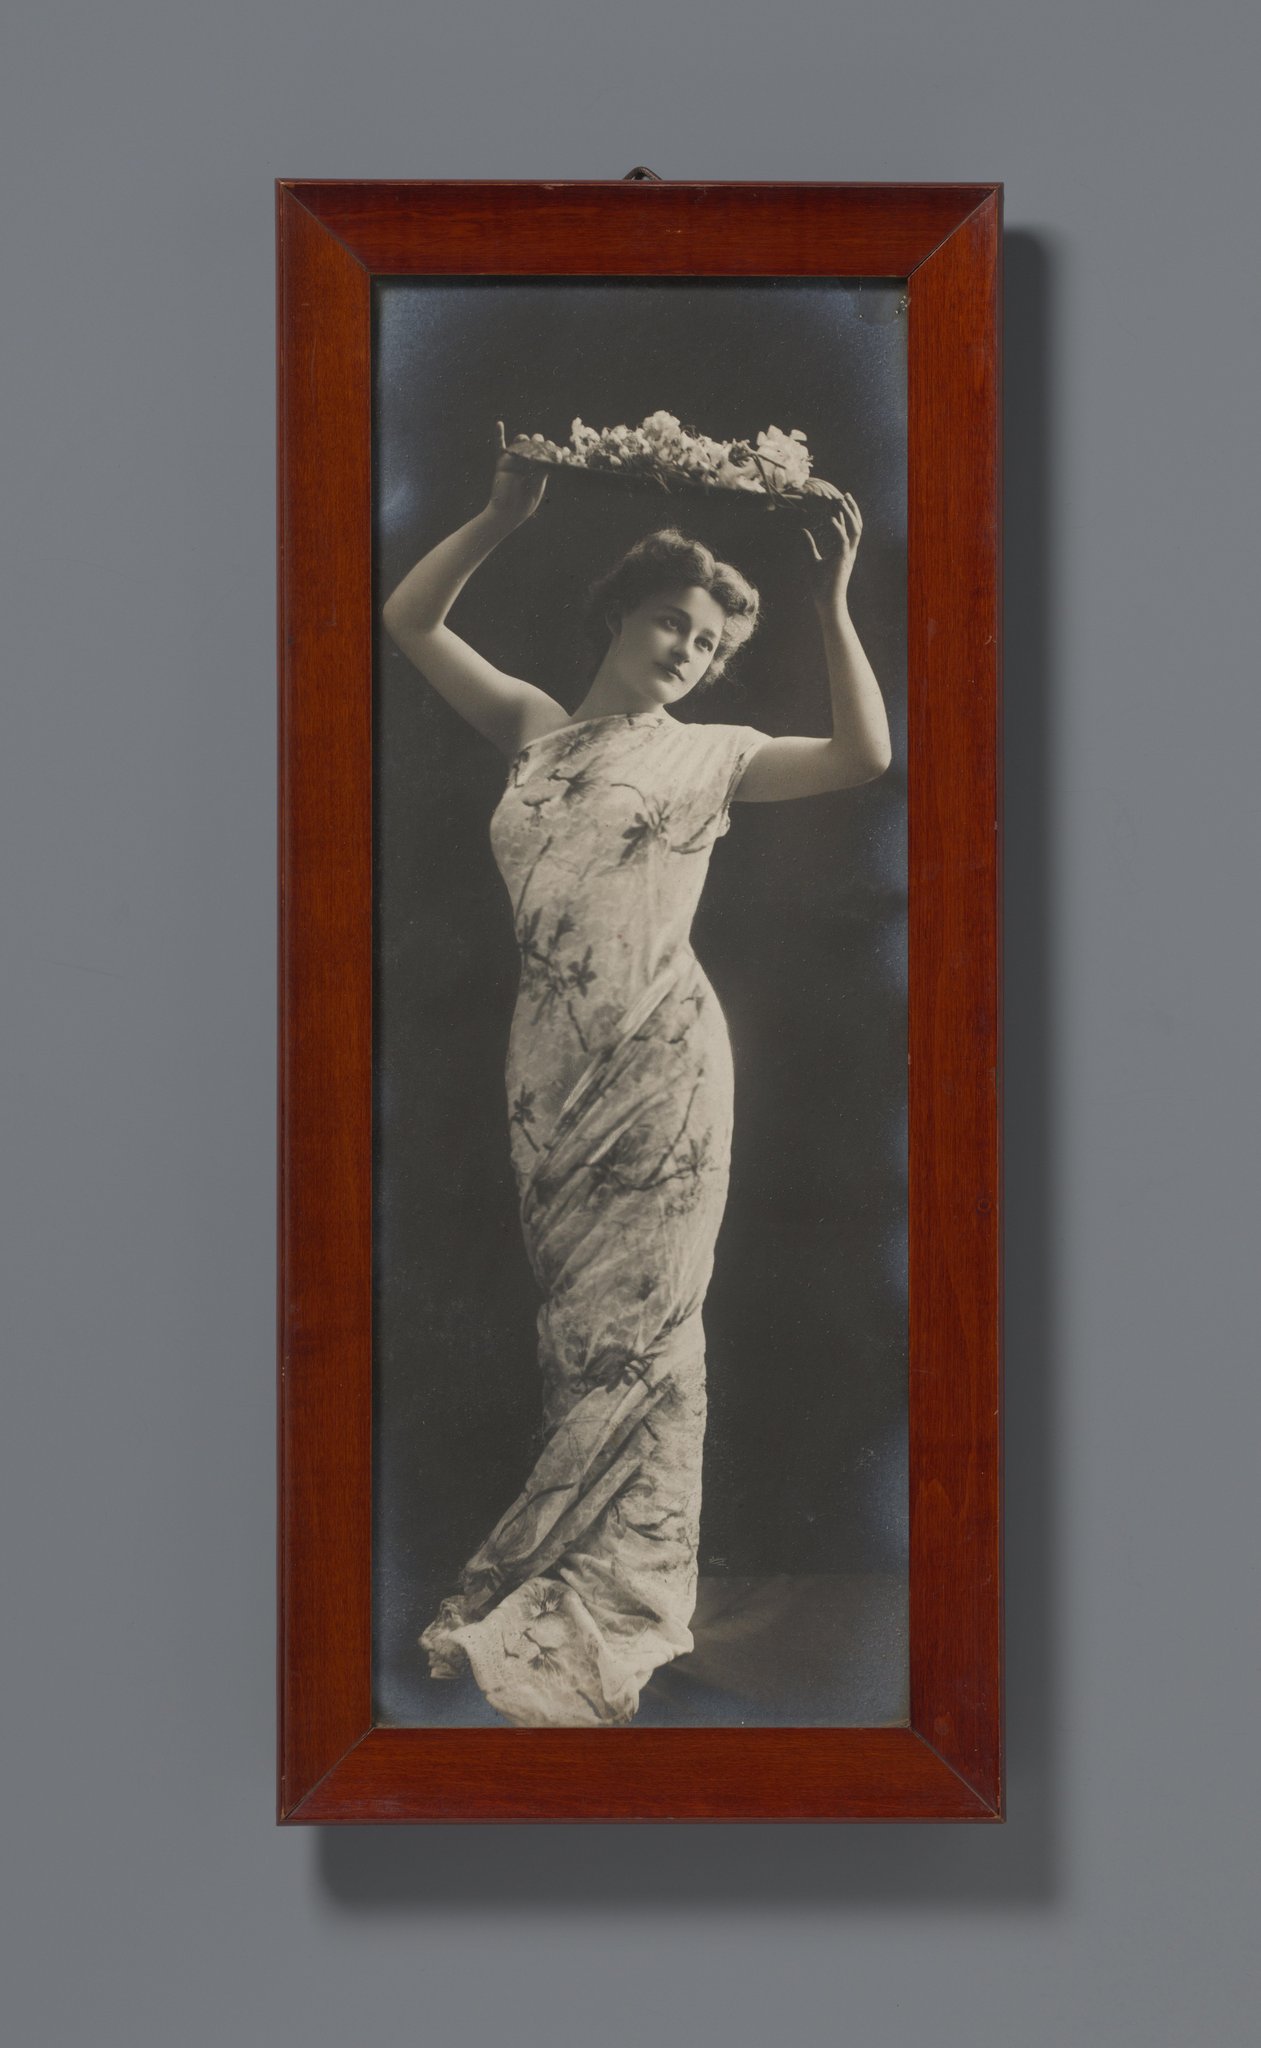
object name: frame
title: Jonge vrouw met een schaal met bloemen boven haar hoofd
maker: charles reutlinger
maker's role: publisher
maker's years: 1816-1880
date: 1900-1920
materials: paper, glass, metal, wood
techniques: gelatin silver print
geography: paris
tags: adolescent, young woman, maiden, cut flowers; nosegay, bunch of flowers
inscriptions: inscription: ‘Reutlinger/ PARIS’